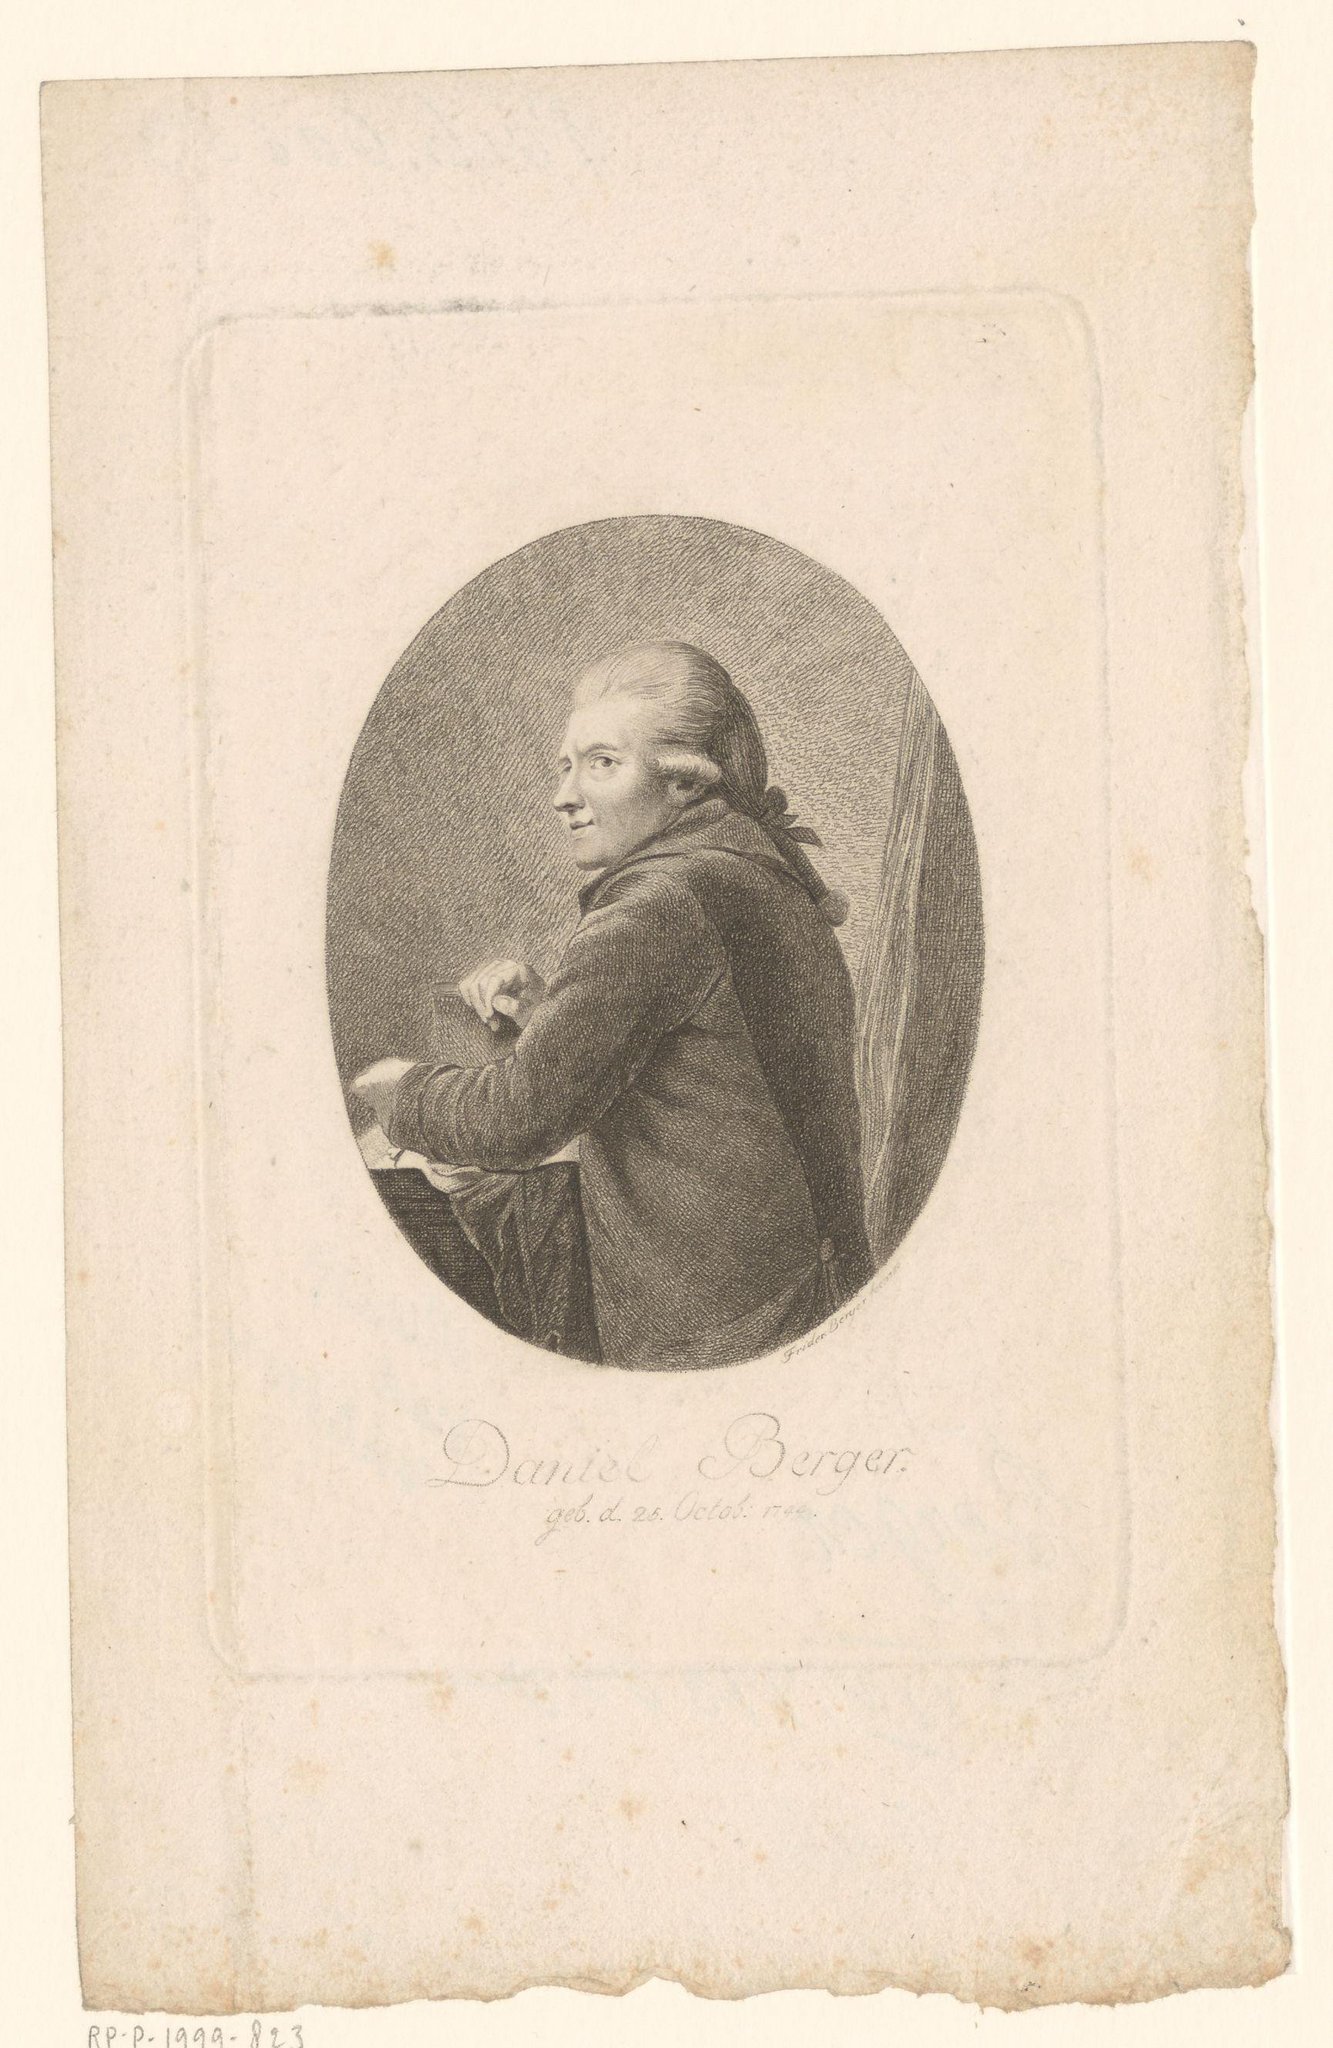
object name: print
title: Portret van Daniel Berger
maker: friedrich gottlieb berger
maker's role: print maker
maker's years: 1713-1797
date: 1786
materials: paper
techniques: etching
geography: berlin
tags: berlin, print maker, daniel berger, portrait, self-portrait of artist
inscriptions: collector's mark: Lugt 2228, collector's mark: Lugt 2760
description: Prent ook gebruikt in: Rost, Carl Christian Heinrich. Anzeige sämmtlicher Werke von Herrn Daniel Berger. Leipzig: Rostischen Kunsthandlung, 1792.